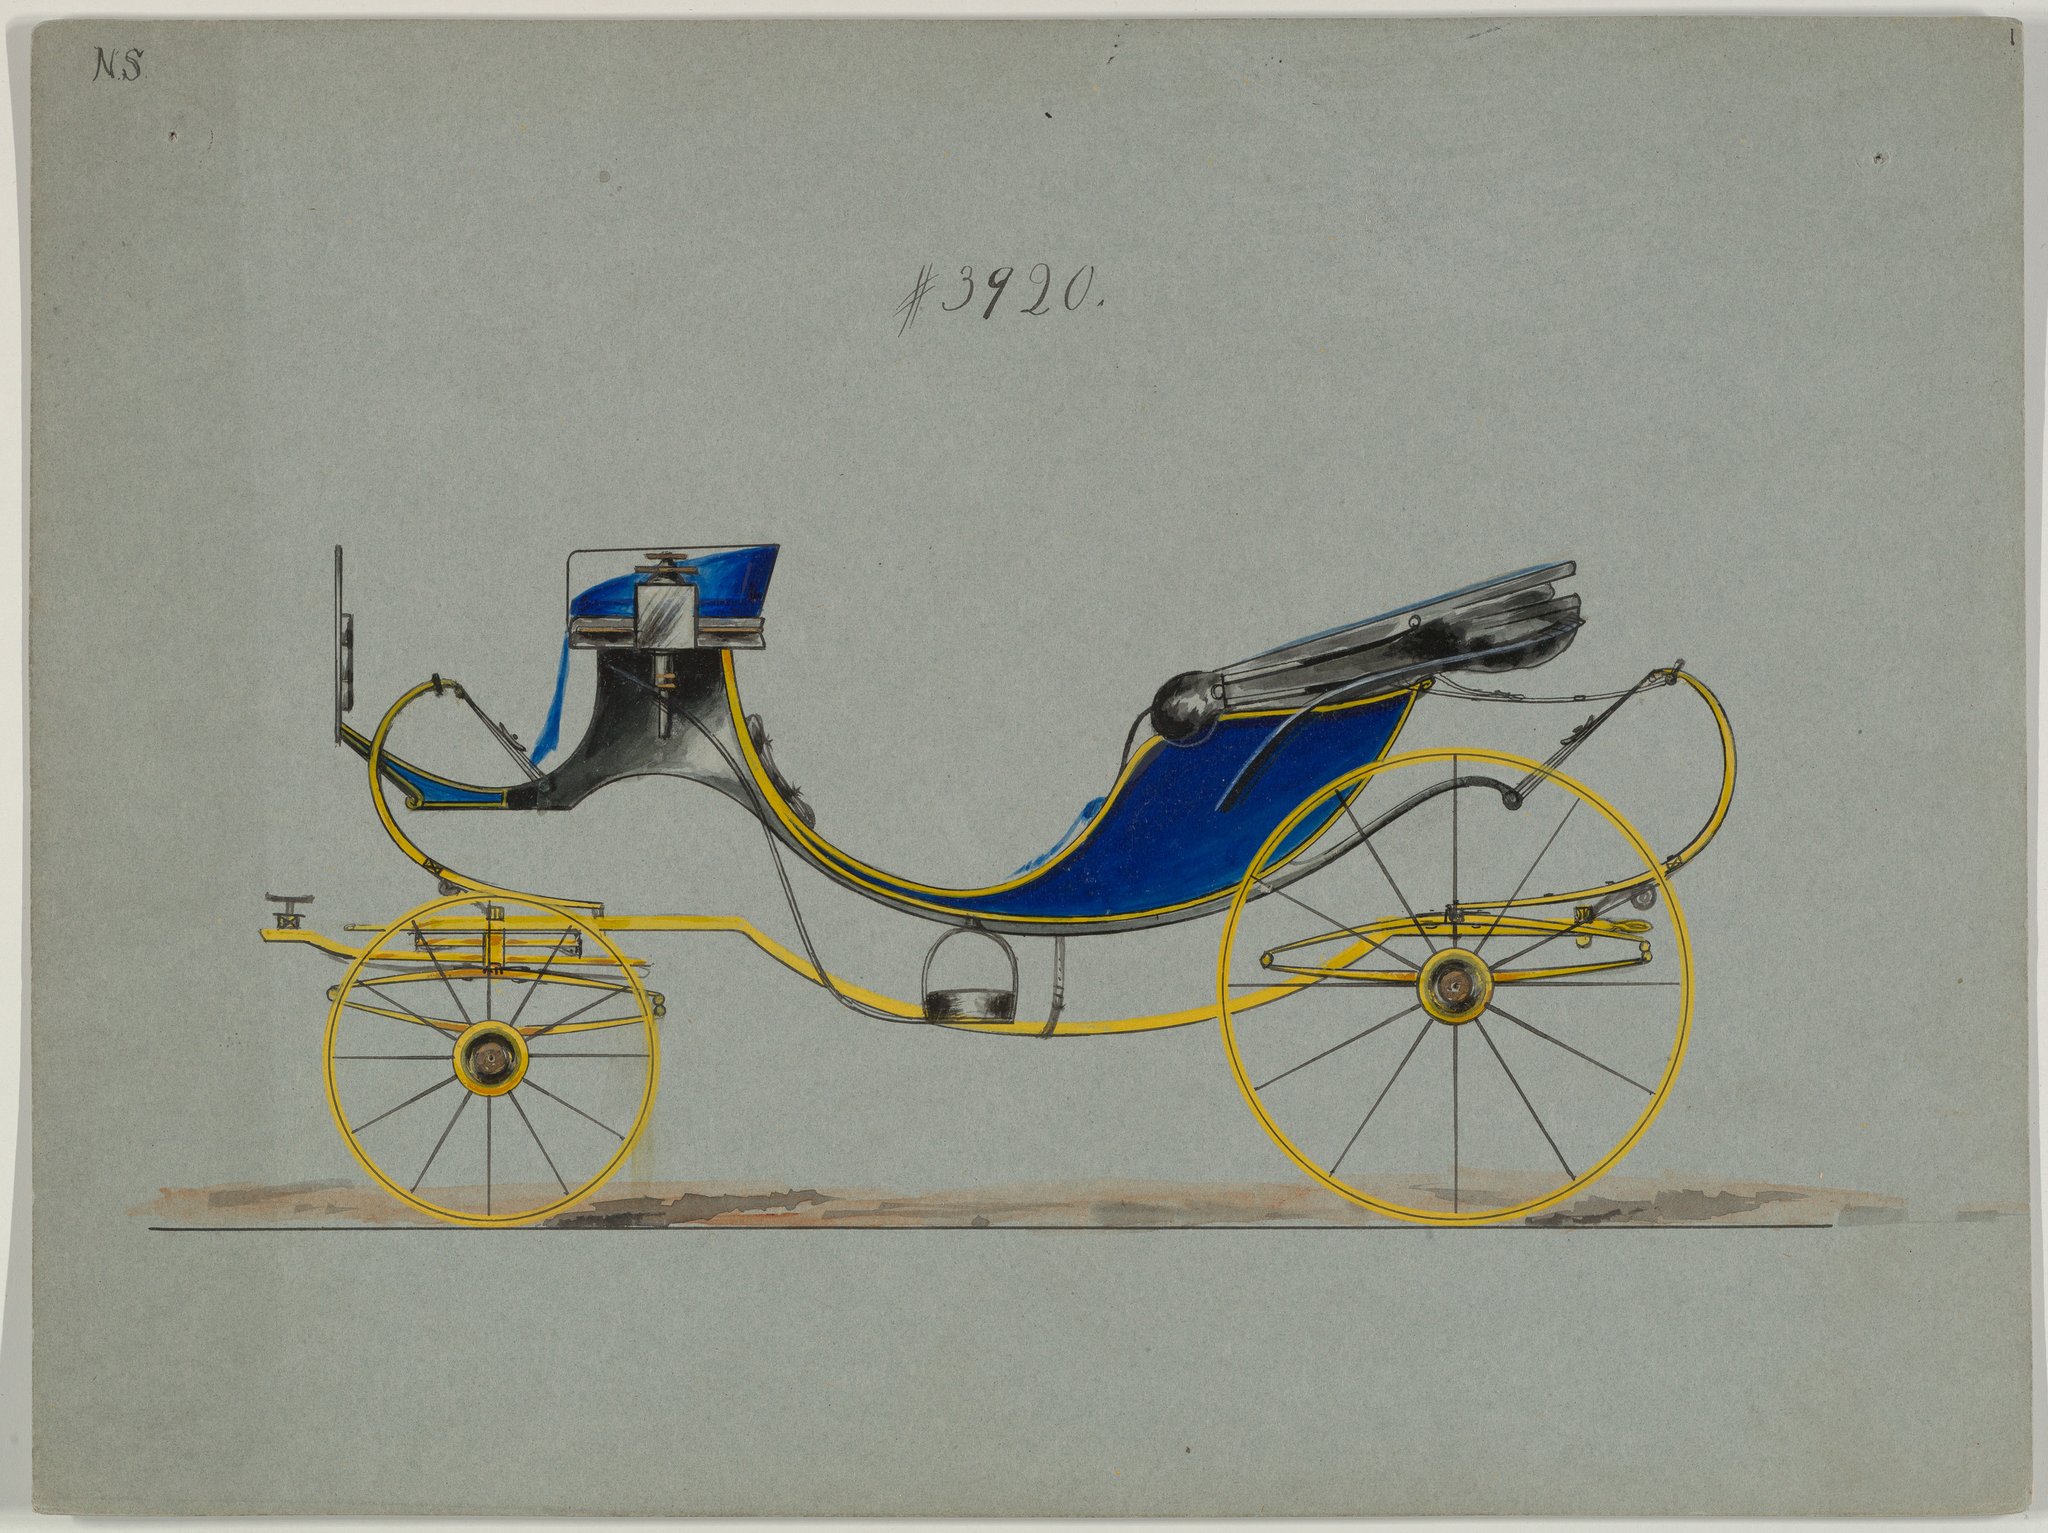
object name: drawing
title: Design for 8 spring Victoria, no. 3920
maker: brewster & co.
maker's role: manufacturer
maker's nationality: american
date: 1884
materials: gum arabic, ink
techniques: pen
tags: carriages